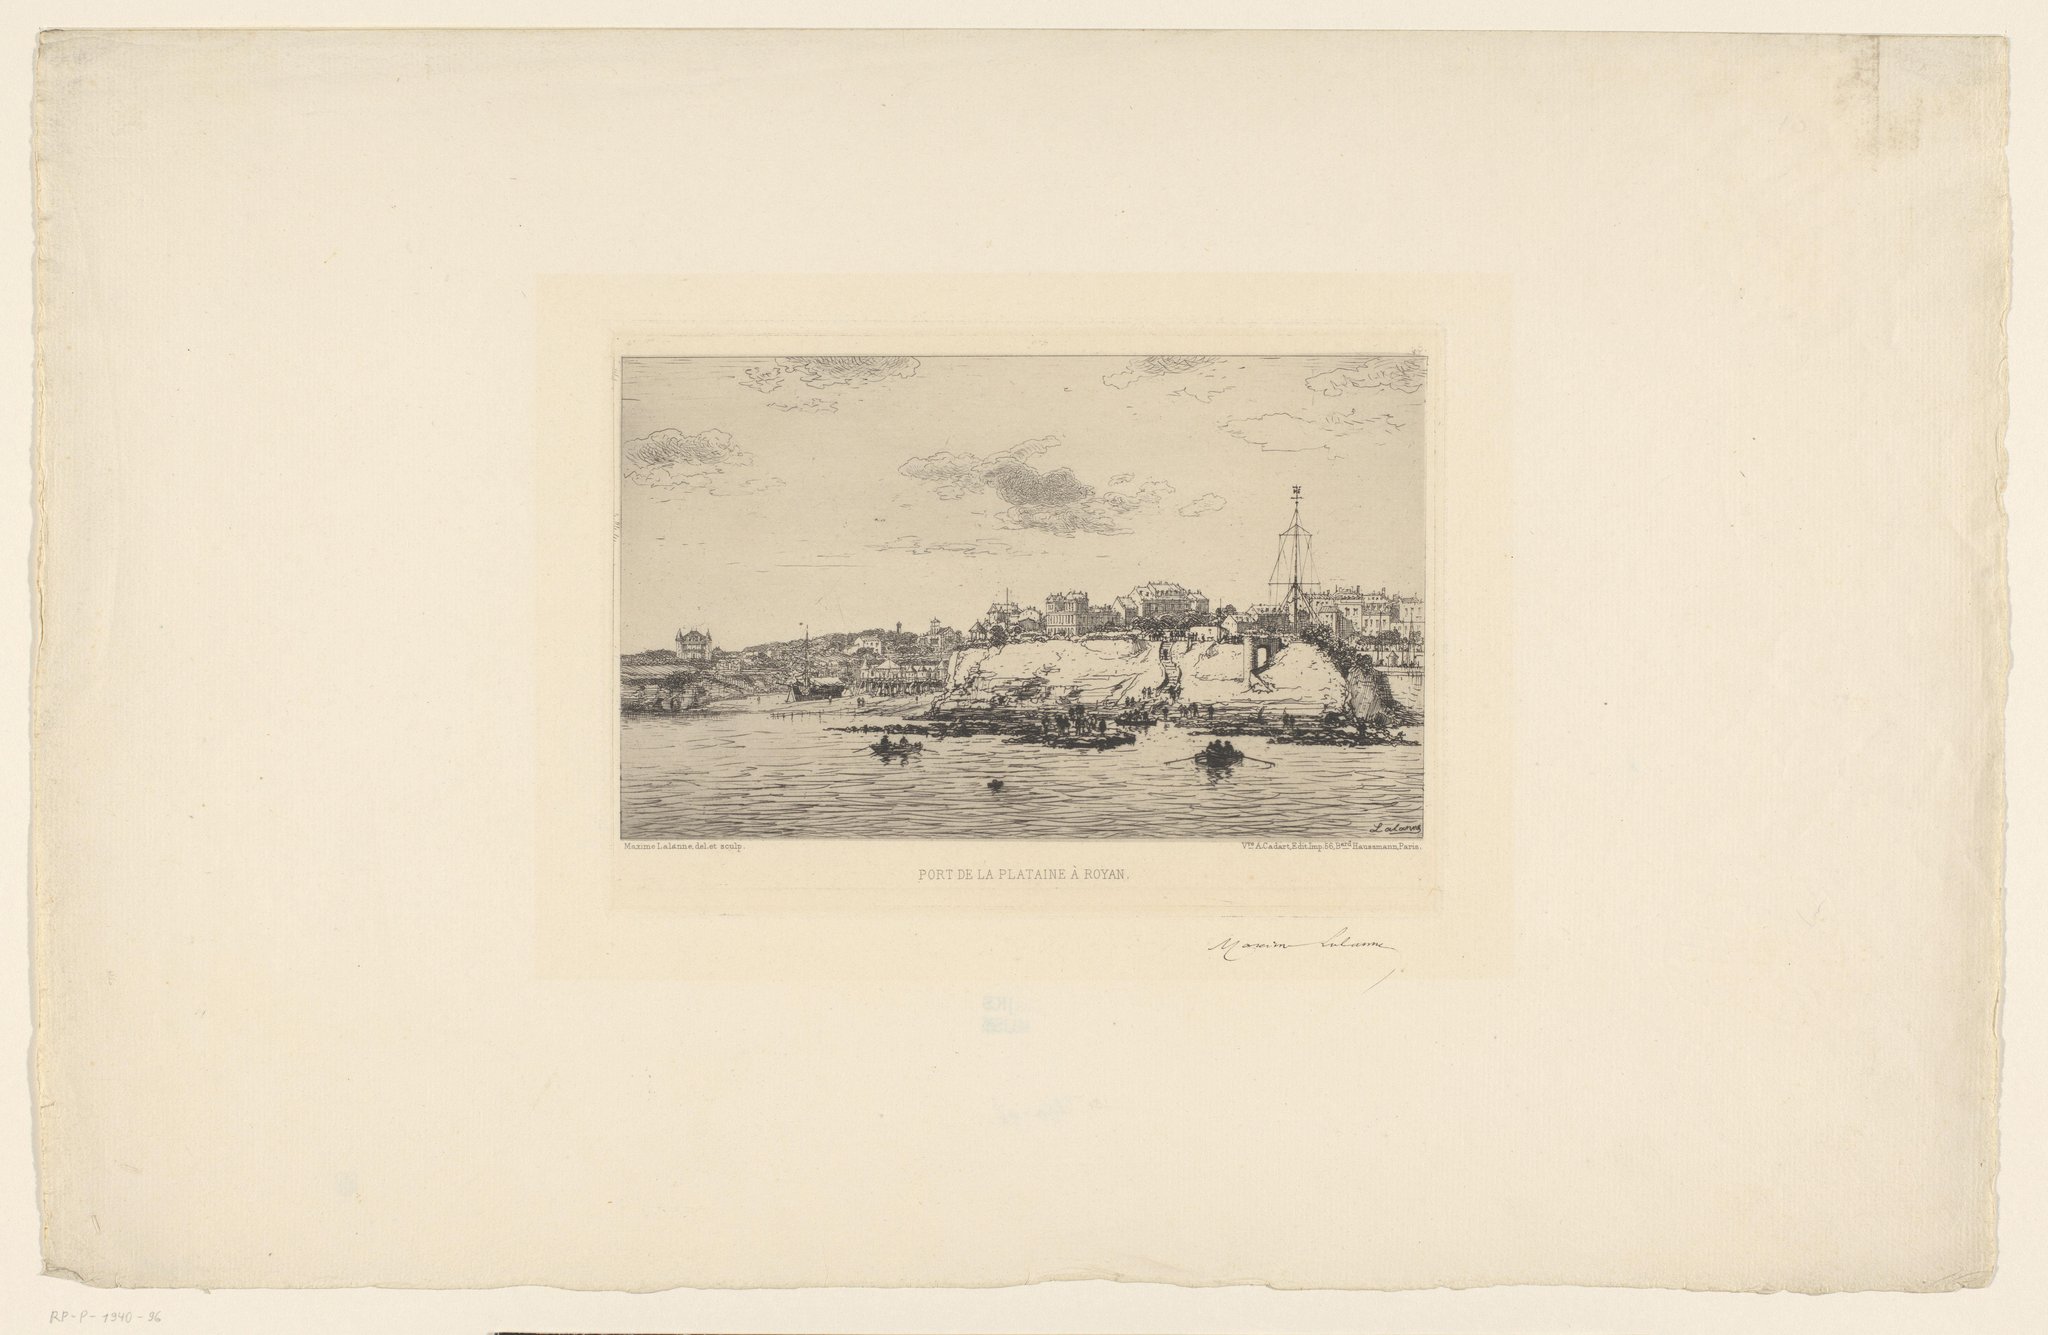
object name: print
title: Port de la Plataine à Royan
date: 1876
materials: paper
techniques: drypoint, engraving, etching, intaglio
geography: paris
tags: harbour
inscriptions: collector's mark: Lugt 2760, collector's mark: Lugt 2166, watermark